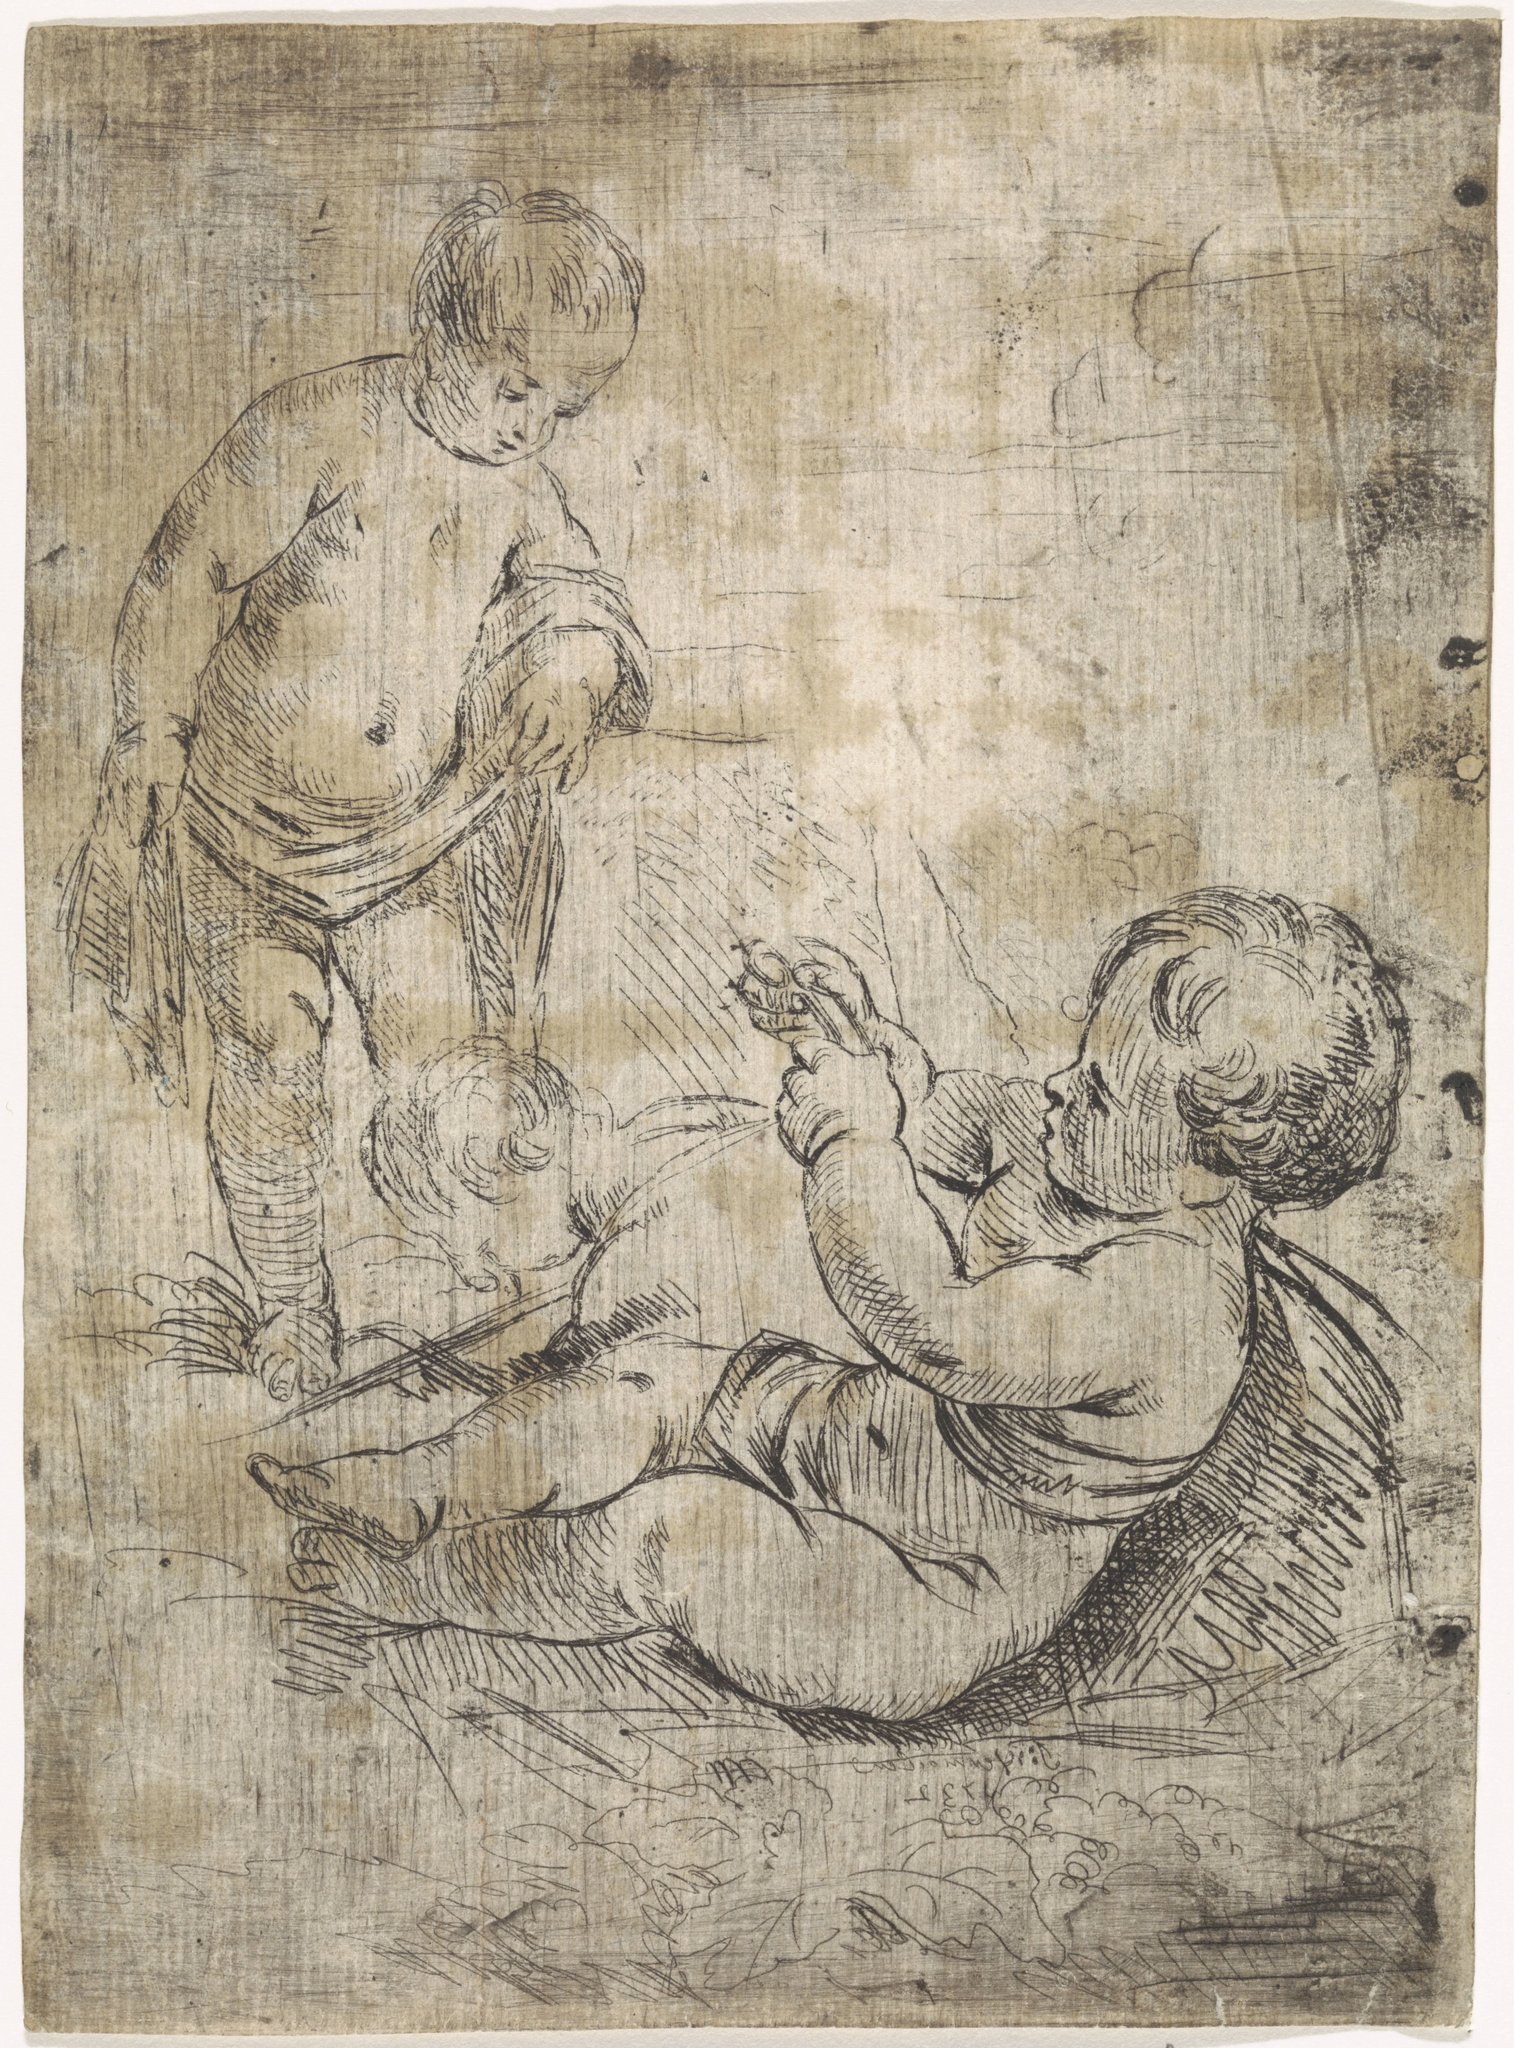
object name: print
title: Spelende kinderen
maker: j. vermeulen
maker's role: print maker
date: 1700-1800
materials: paper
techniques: etching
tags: children's games and plays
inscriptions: collector's mark: Lugt 514, collector's mark: Lugt 2228